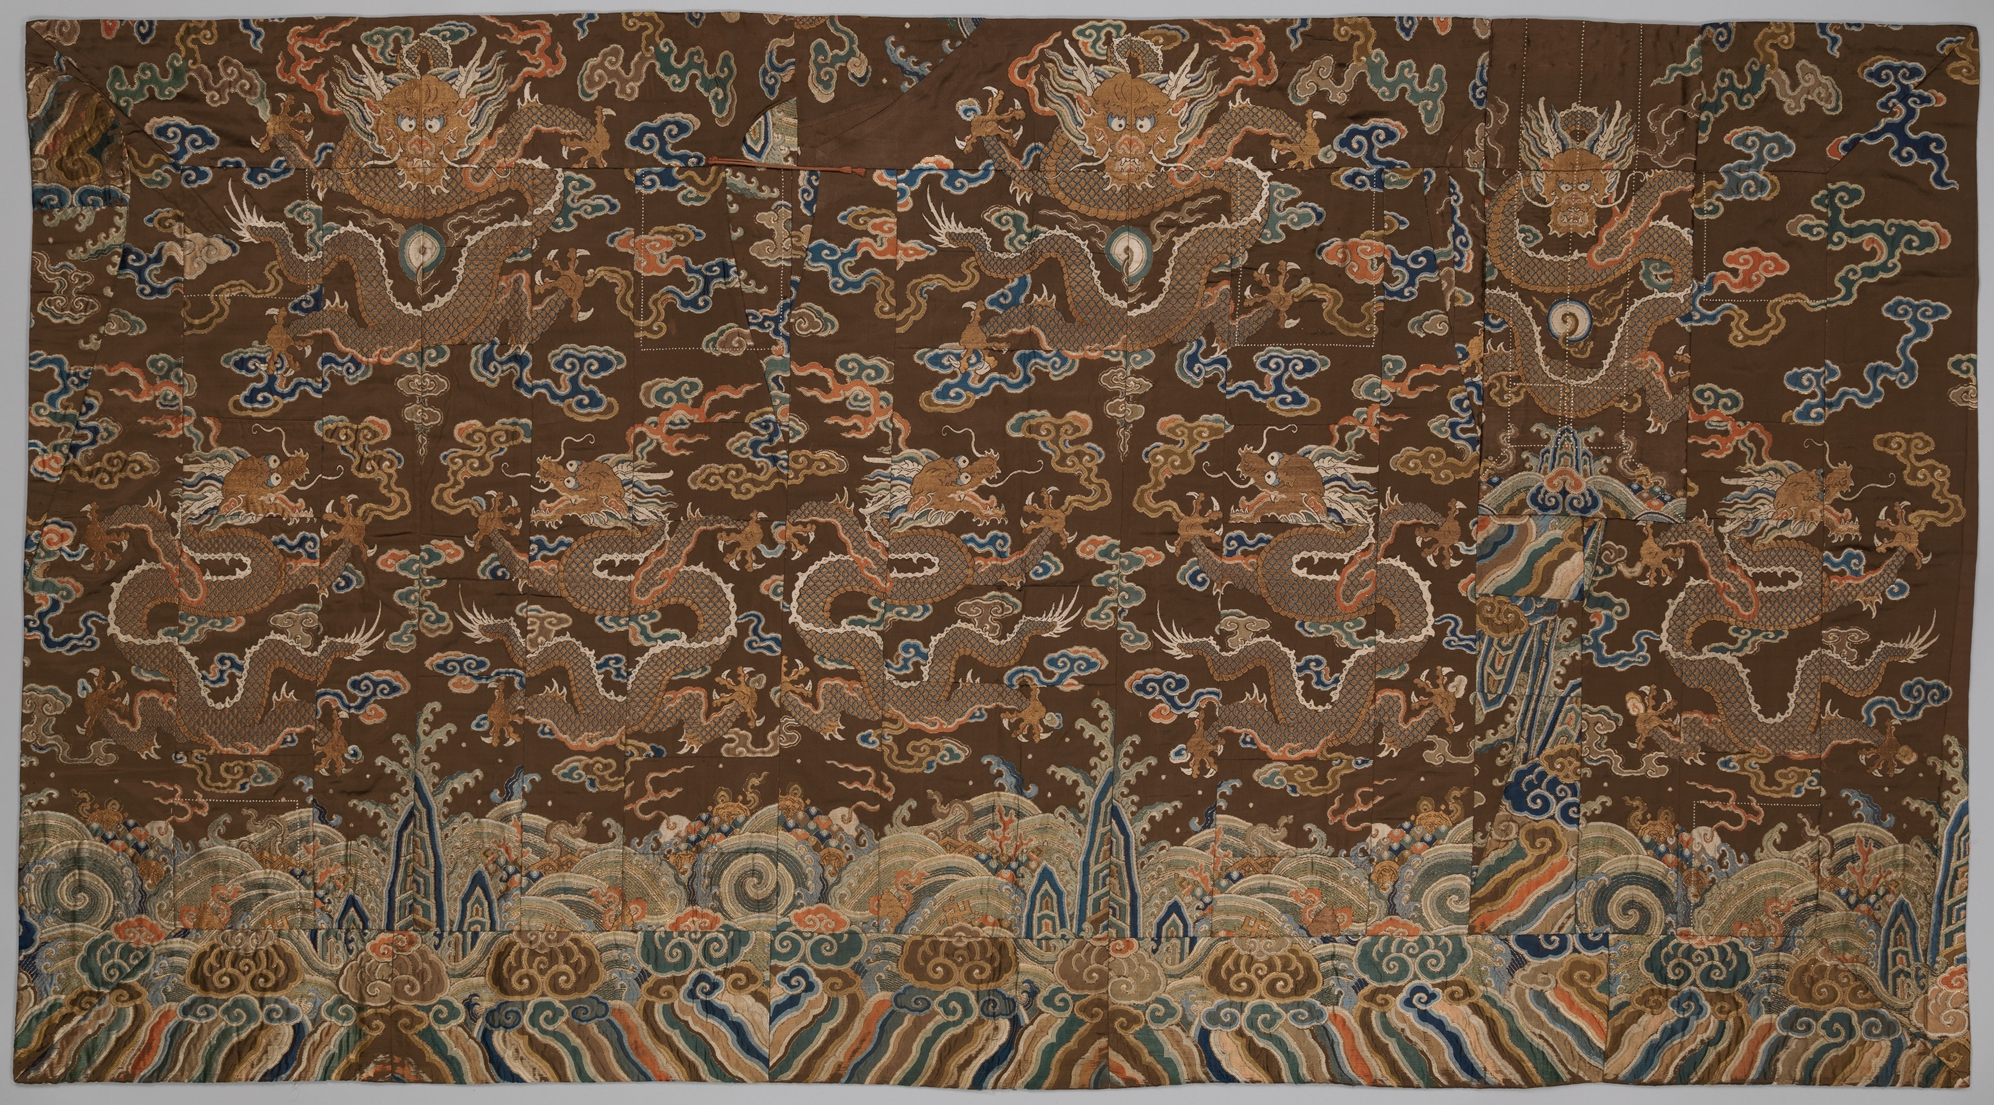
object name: robe, priest's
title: Buddhist Priest's Vestment made from a Chinese Robe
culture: japanese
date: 1701-1800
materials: metal thread, silk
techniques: brocade, embroidery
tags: dragons